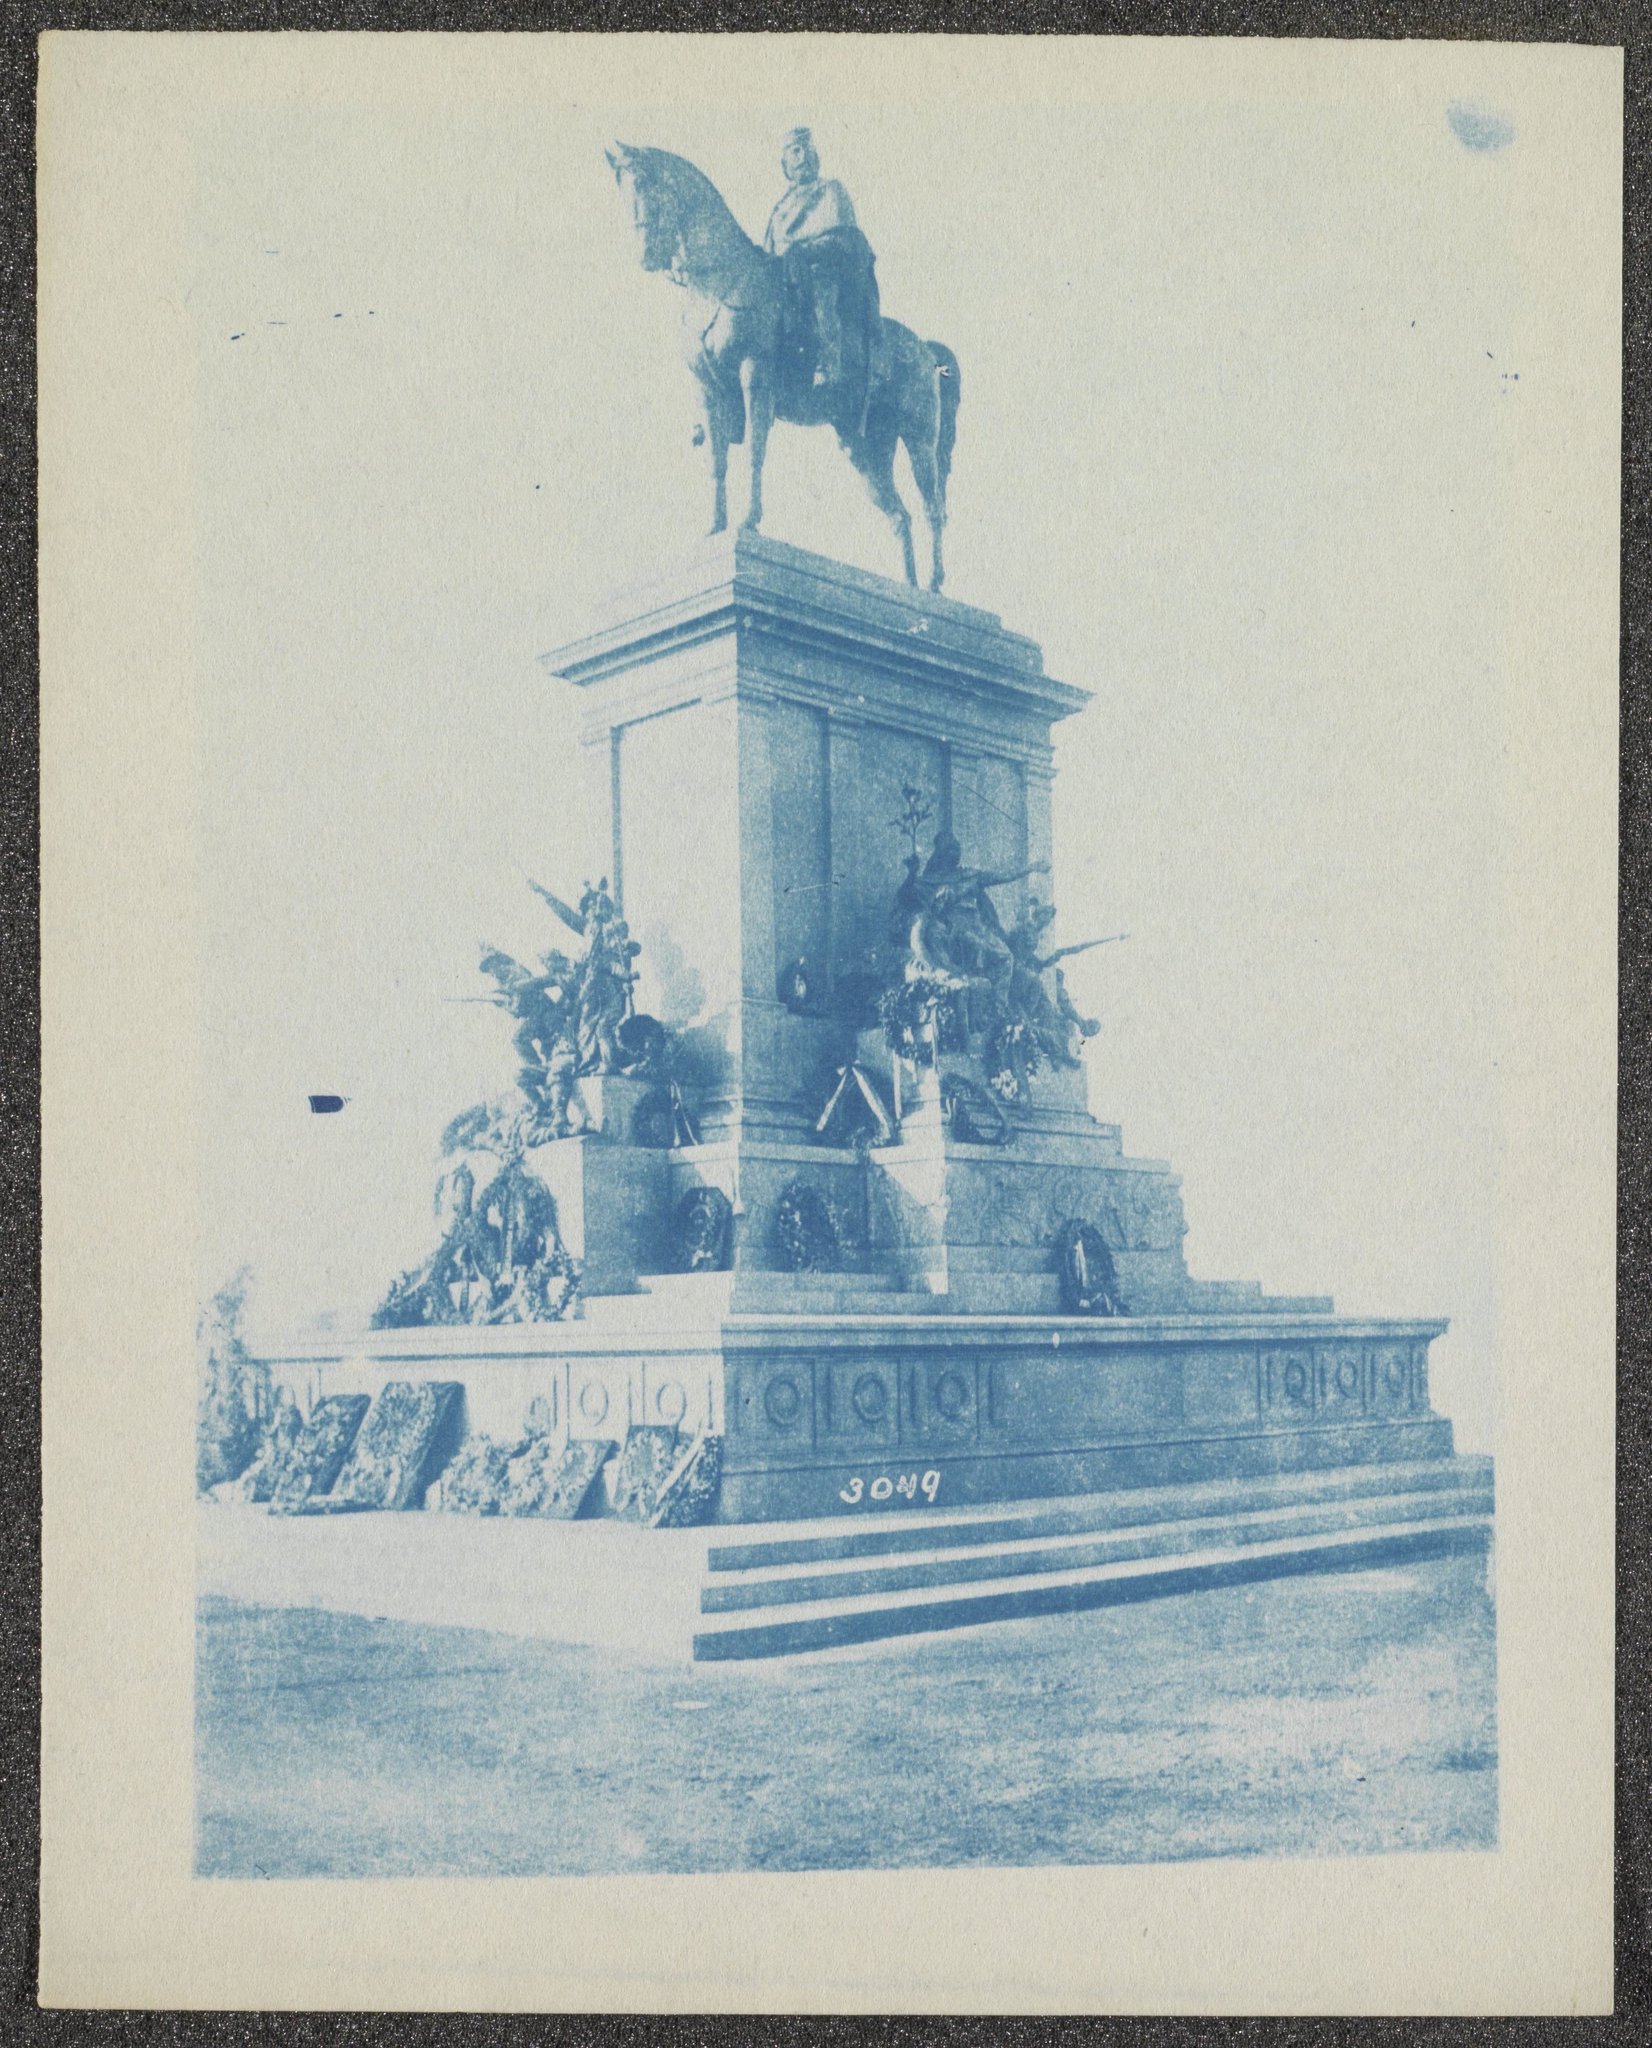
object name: photograph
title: Fotoreproductie van foto van het ruiterstandbeeld van Giuseppe Garibaldi te Rome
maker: Anonymous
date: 1880-1905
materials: paper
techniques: cyanotype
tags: equestrian statue, rome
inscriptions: inscription: ‘Statue of Garibaldi/ Rome.’, number: ‘3049’